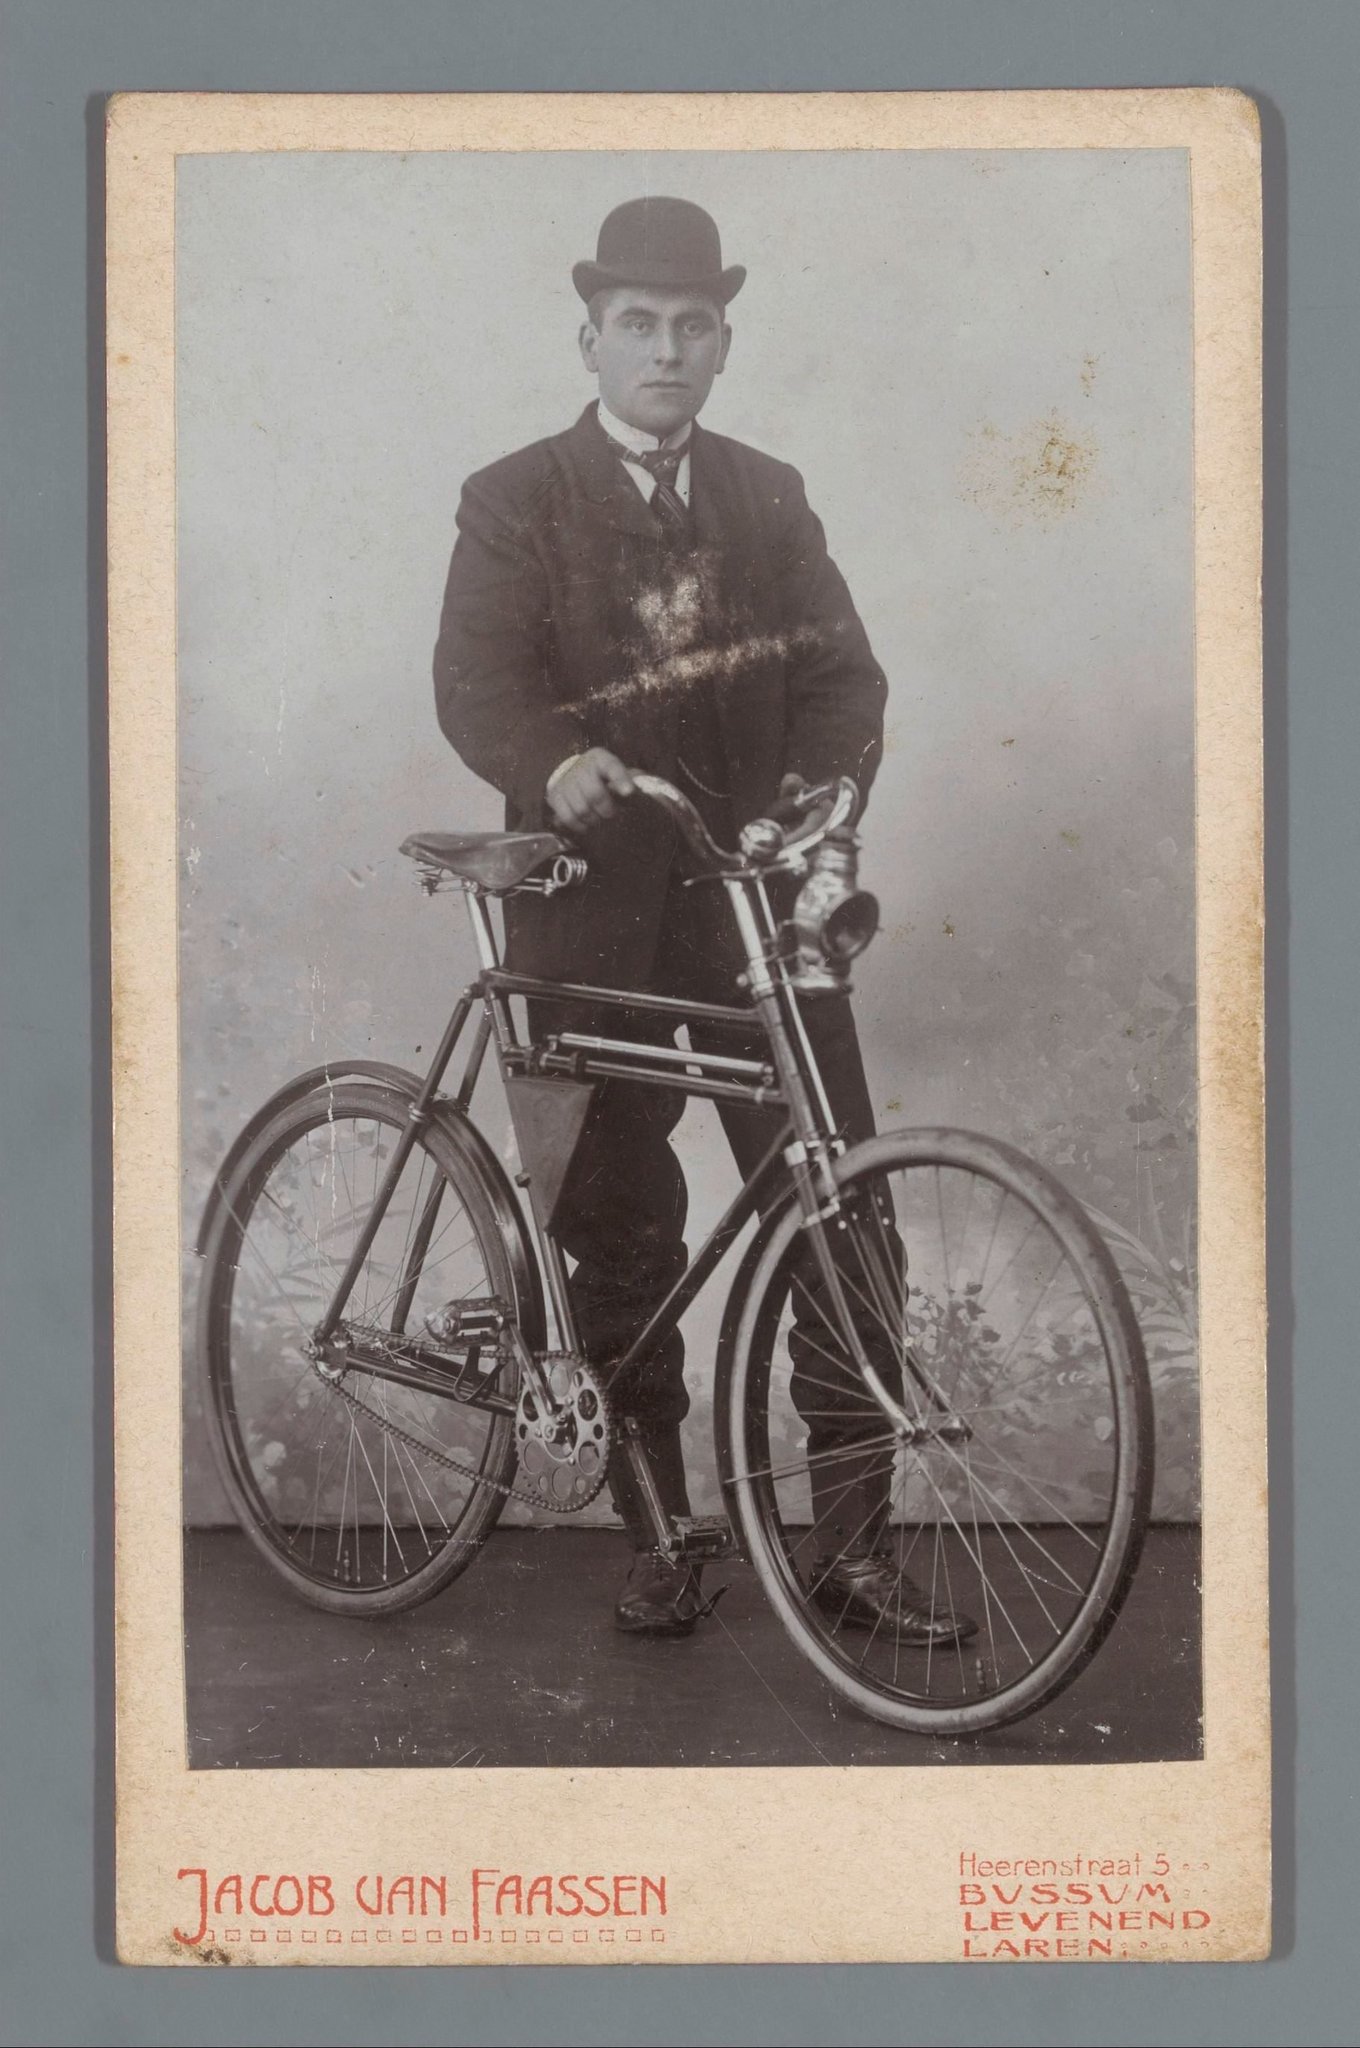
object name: carte de visite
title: Portret van een onbekende man met een fiets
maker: jac. van faassen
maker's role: fotograaf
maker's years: 1876-1943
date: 1890-1905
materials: cardboard, photographic support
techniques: gelatin silver print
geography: bussum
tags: adult man, bicycle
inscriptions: inscription: ‘Jacob van Gaassen Heerenstraat 5 Bussum Levenend Laren’